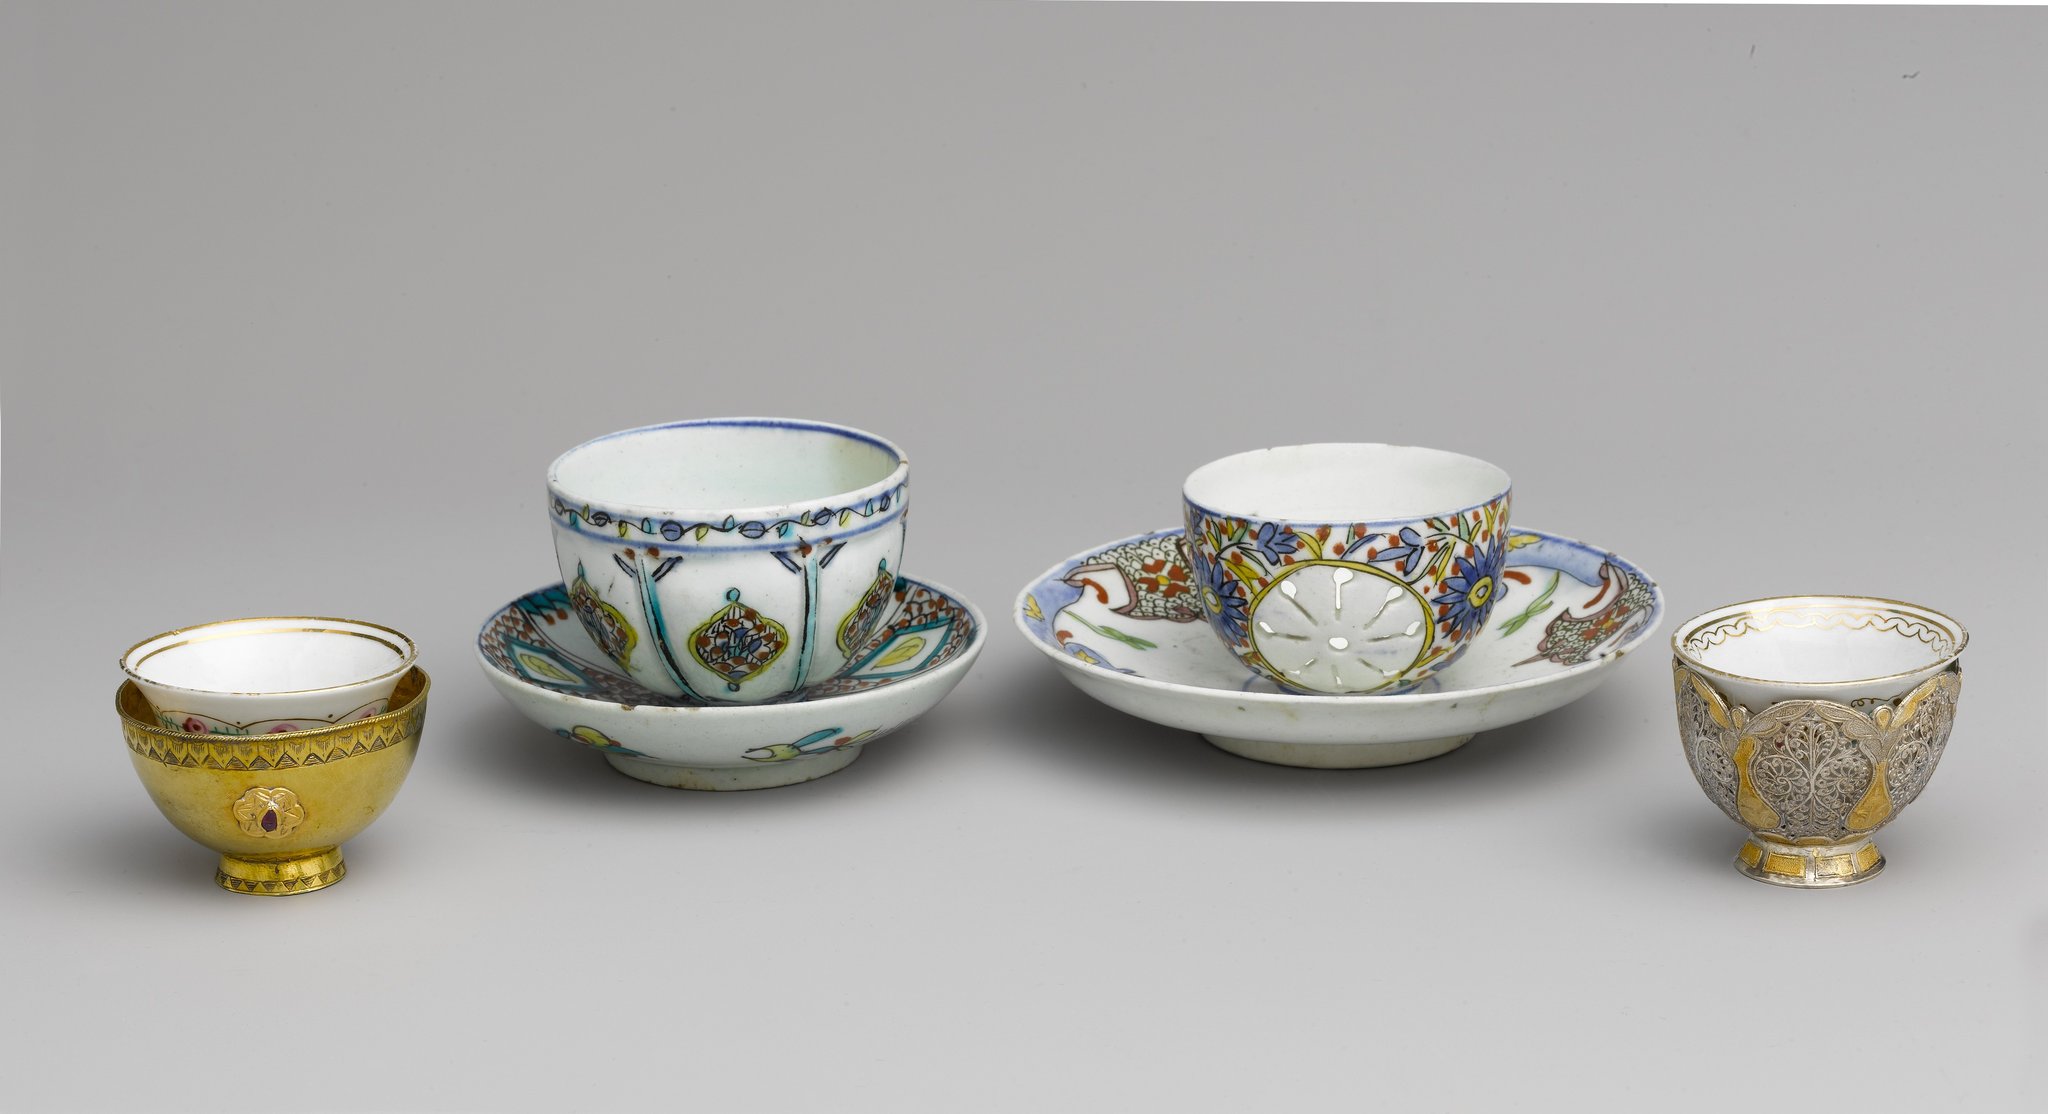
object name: saucer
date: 1701-1800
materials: glaze, stonepaste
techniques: painting, polychrome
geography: turkey